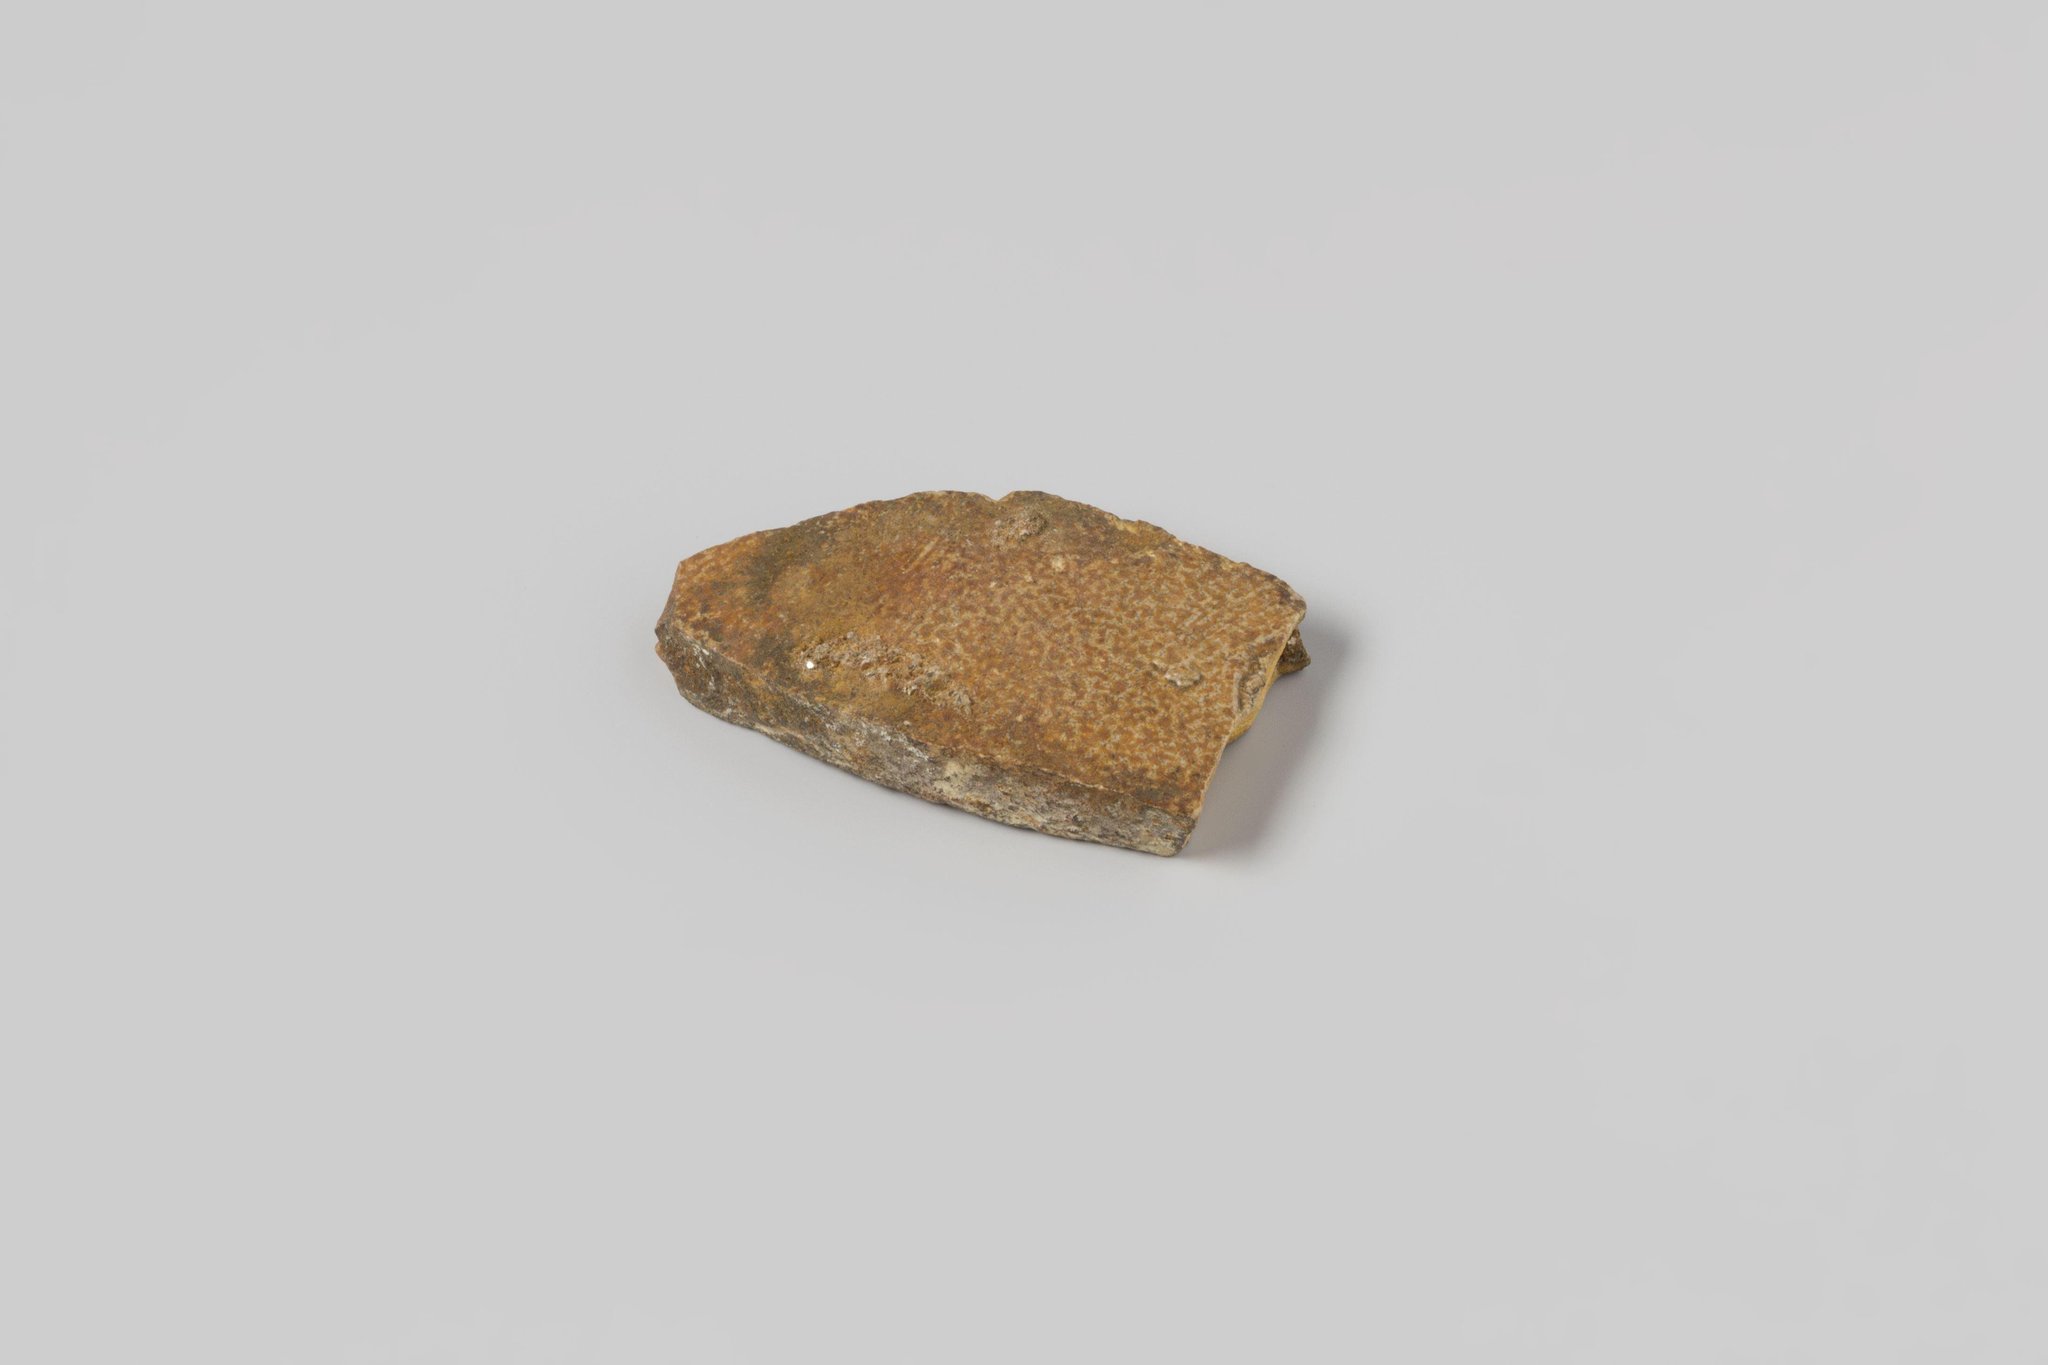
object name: ewer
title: Scherf van een kan uit het wrak van de Oost-Indiëvaarder Hollandia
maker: Anonymous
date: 1700-1743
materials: stoneware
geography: cologne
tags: verenigde oostindische compagnie, hollandia (schip), annet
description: Stoneware, Rhenish, Frechen-ware, jug; fragm of body.